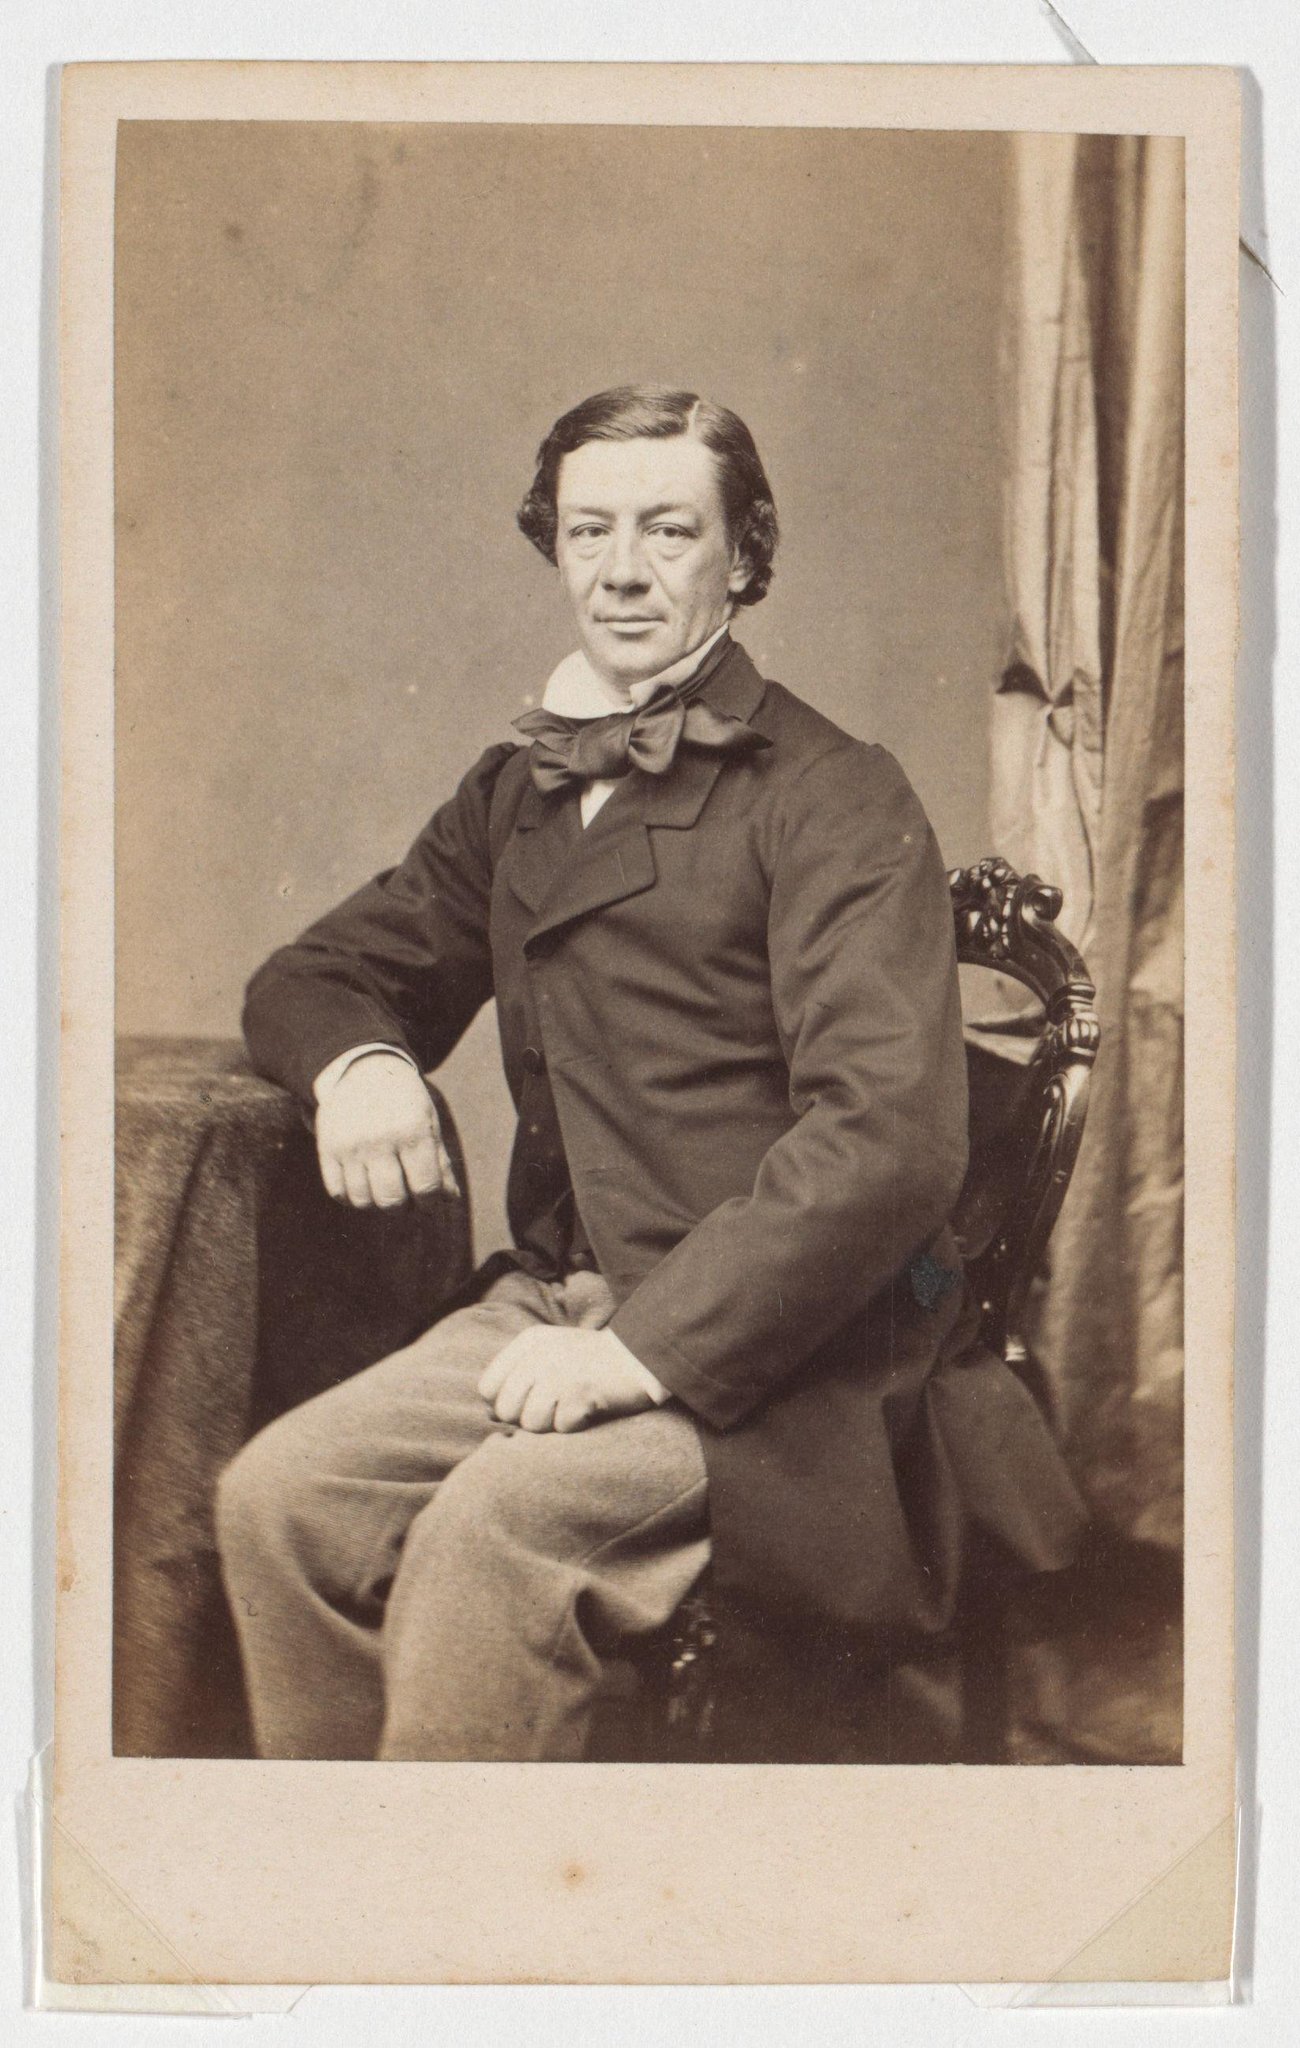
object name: photograph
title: Cartes-de-visite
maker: franz wilhelm deutmann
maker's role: fotograaf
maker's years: 1809-1895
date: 1855-1889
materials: cardboard, paper, photographic support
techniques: albumen print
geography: amsterdam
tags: studio requisites ~ photographer, historical persons not known by name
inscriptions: address: ‘Amsterdam’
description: Cartomanie was a collecting craze. From 1855 hundreds of thousands of these portraits were annually sold worldwide. People had photographs taken of their loved ones, including their pets, and kept them in an album. Portraits of kings, writers, artists, actors, and statesmen were also collected. Photography was no longer the preserve of the wealthy; farmers and maidservants now also stood before the camera.